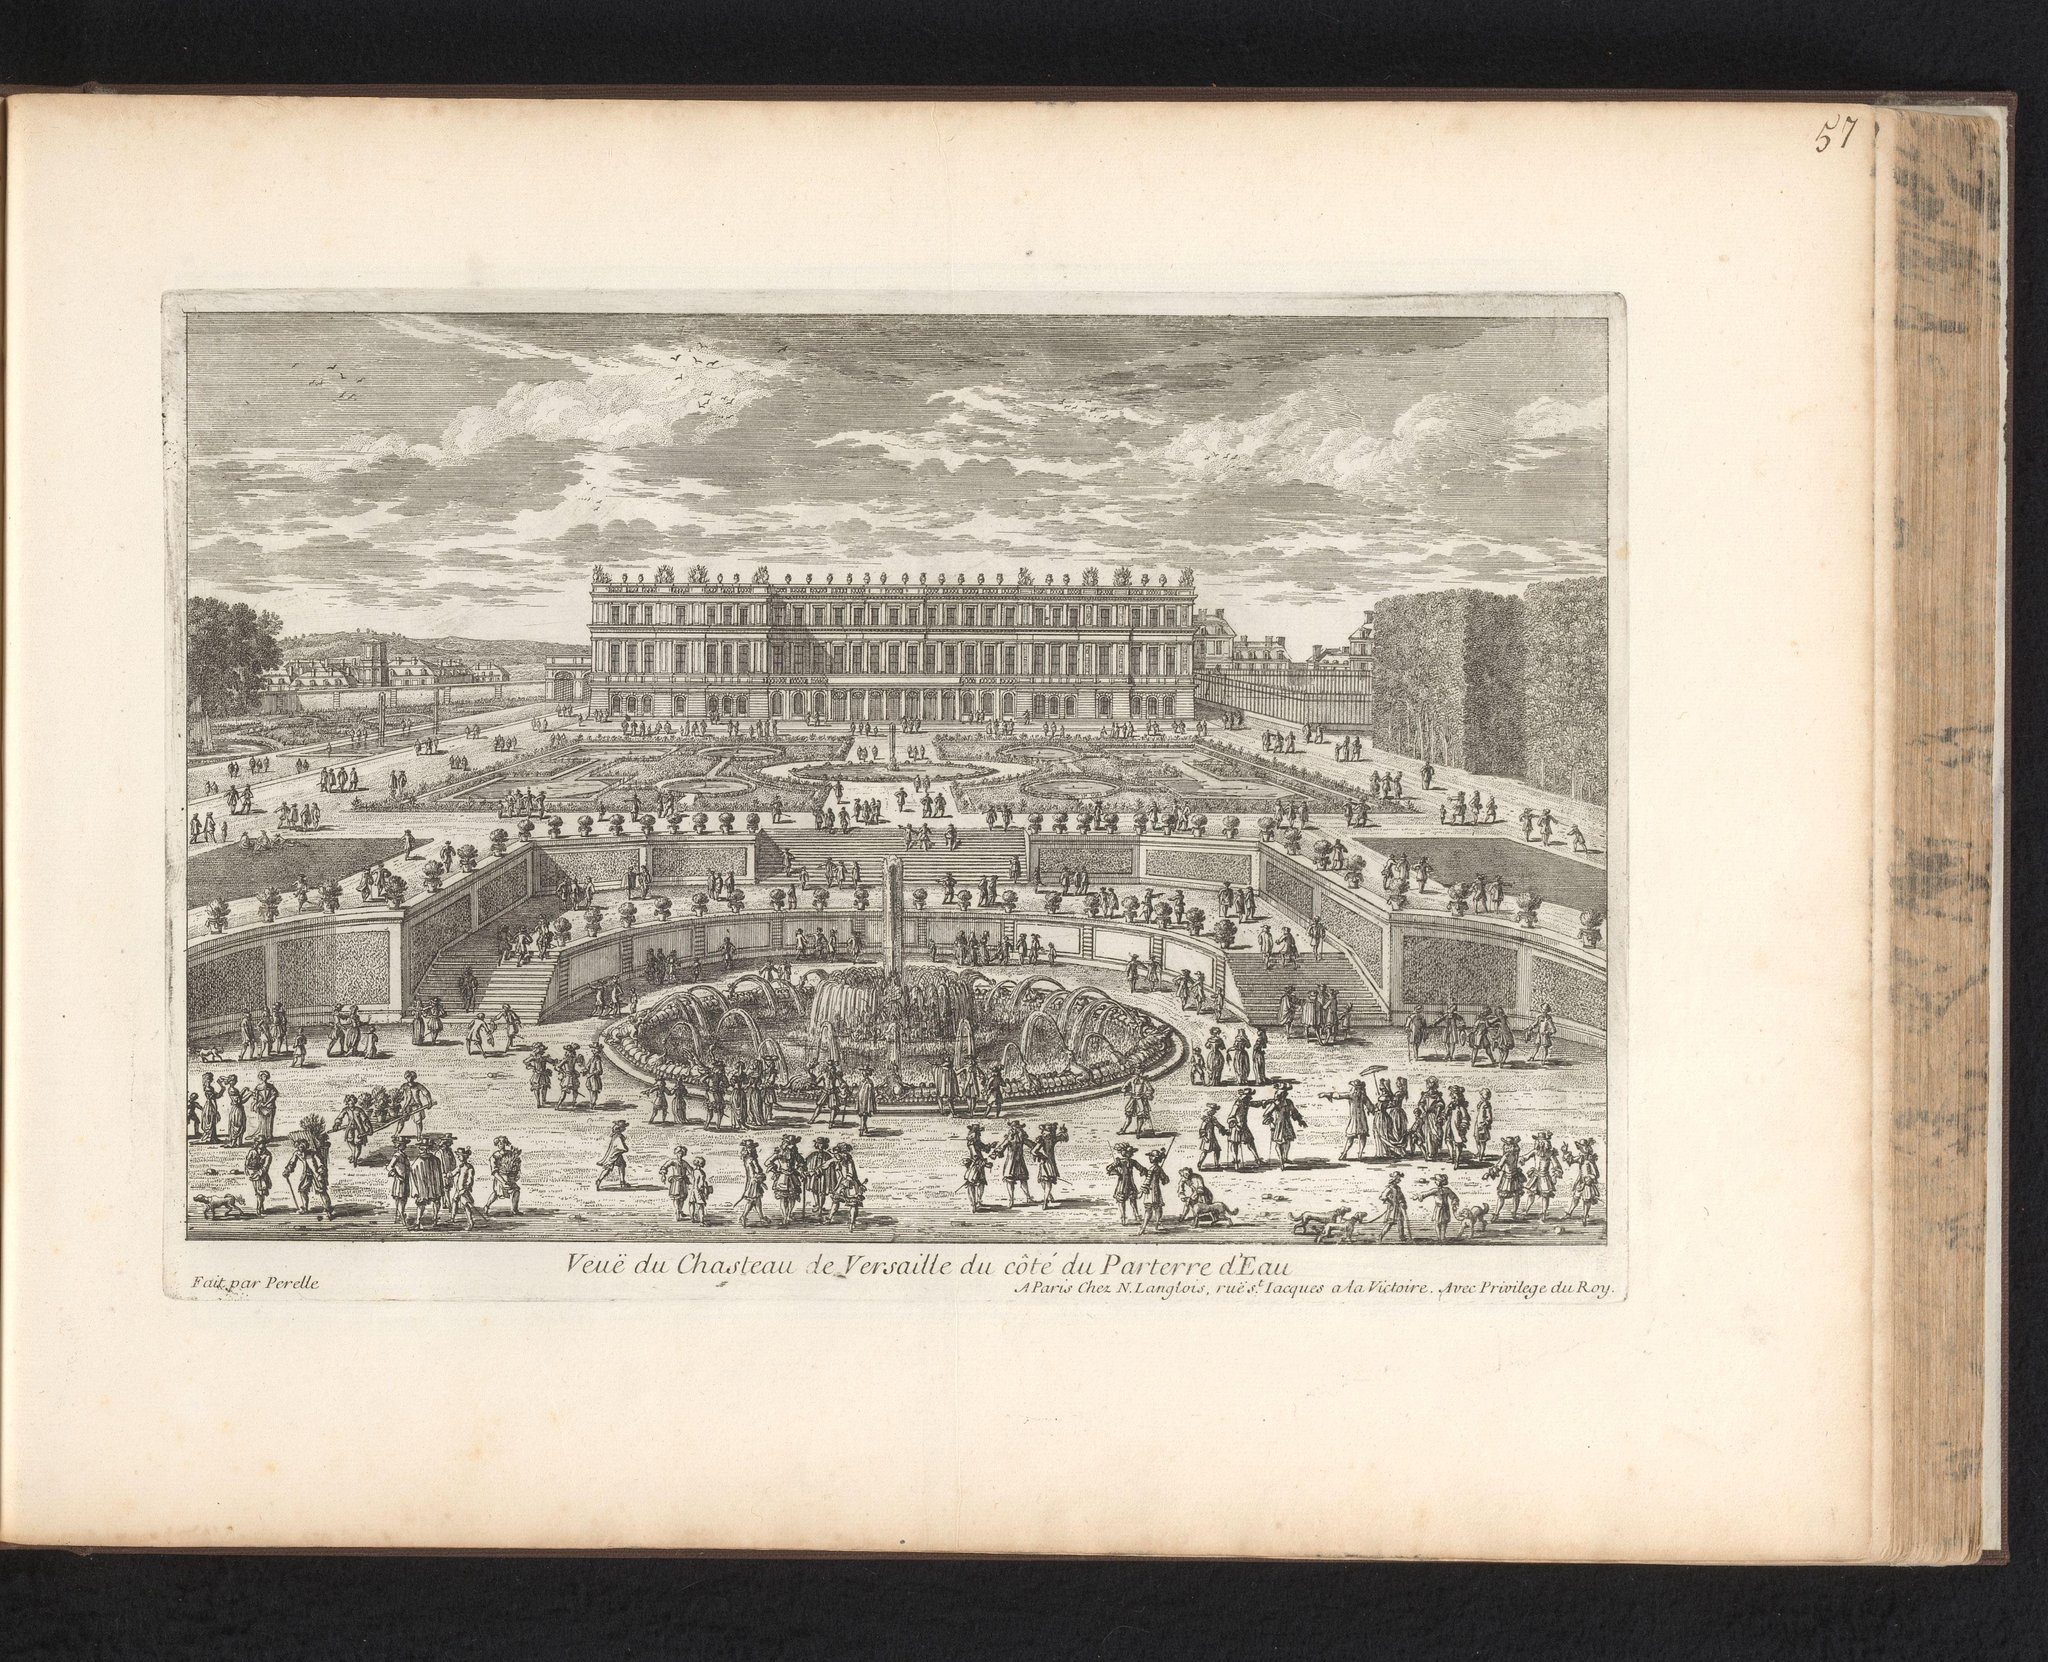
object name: album leaf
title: Gezicht op Versailles met fonteinen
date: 1660-1695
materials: paper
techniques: etching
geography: paris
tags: garden fountain, french or architectonic garden; formal garden, landscape with tower or castle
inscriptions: collector's mark: Lugt 2228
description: Prenten met het signatuur 'Perelle' kunnen zowel door vader Gabriel als door zonen Nicolas en Adam gemaakt zijn. De uitgevers vader en zoon Nicolas Langlois worden allebei vermeld als N. Langlois op hetzelfde adres.